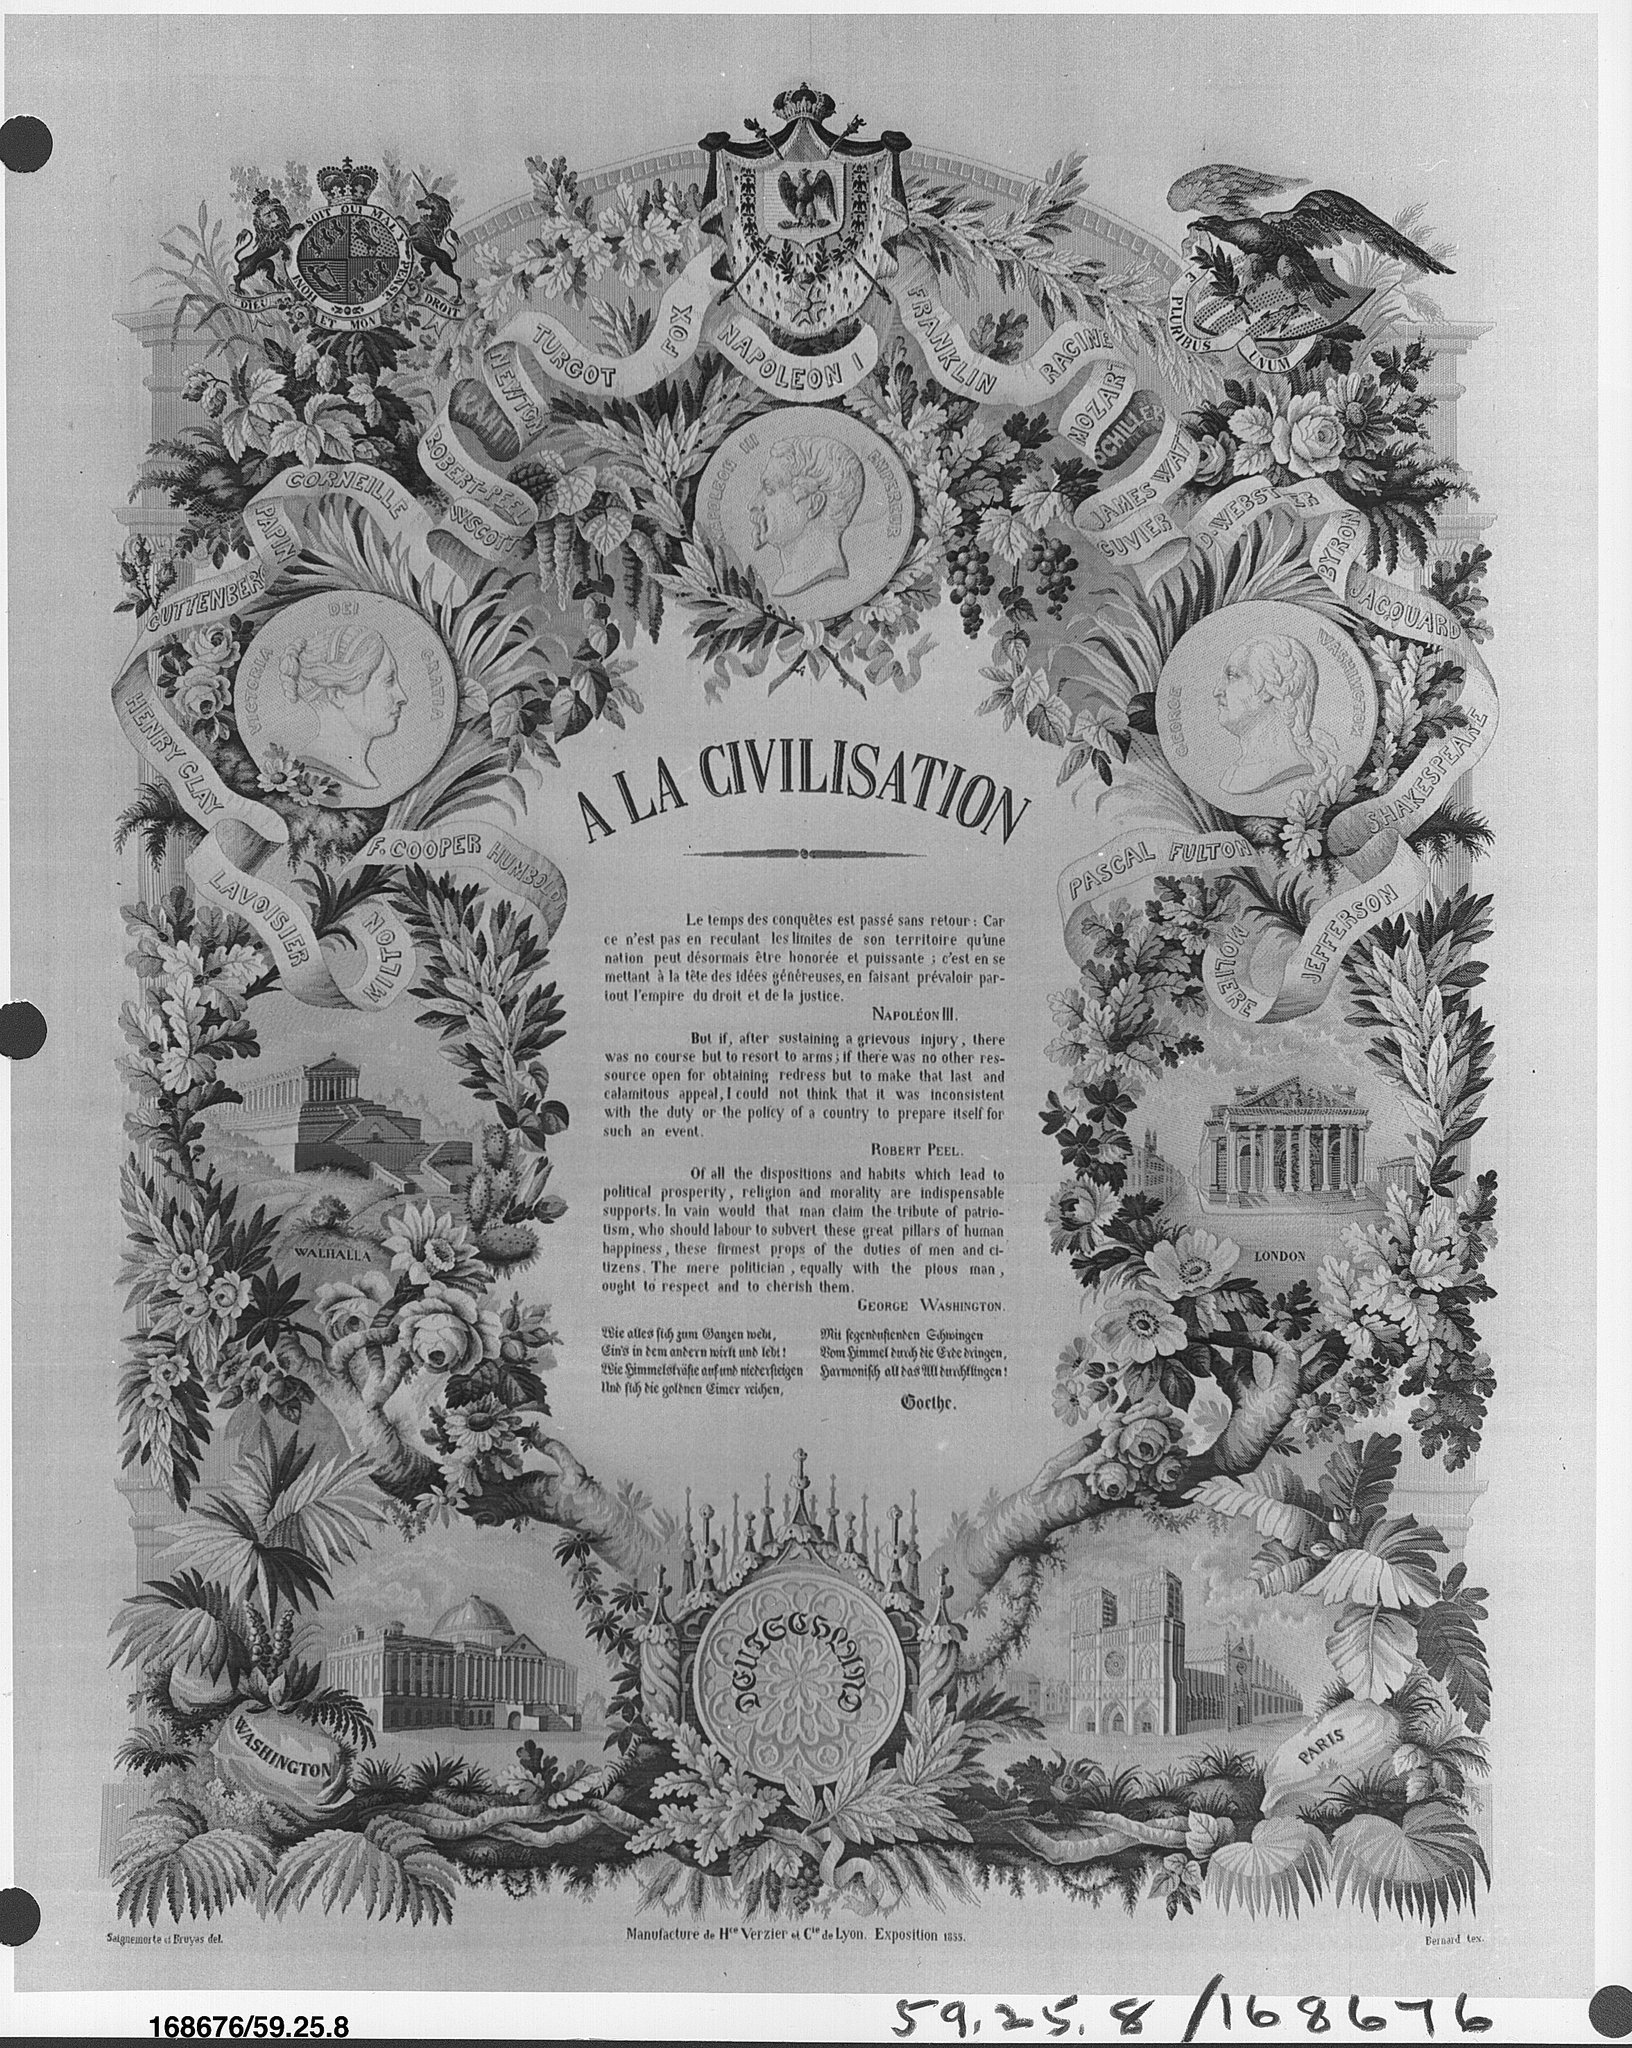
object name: panel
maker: horace verzier et cie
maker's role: manufactory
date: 1855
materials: silk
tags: george washington,napoleon iii,profiles,coat of arms